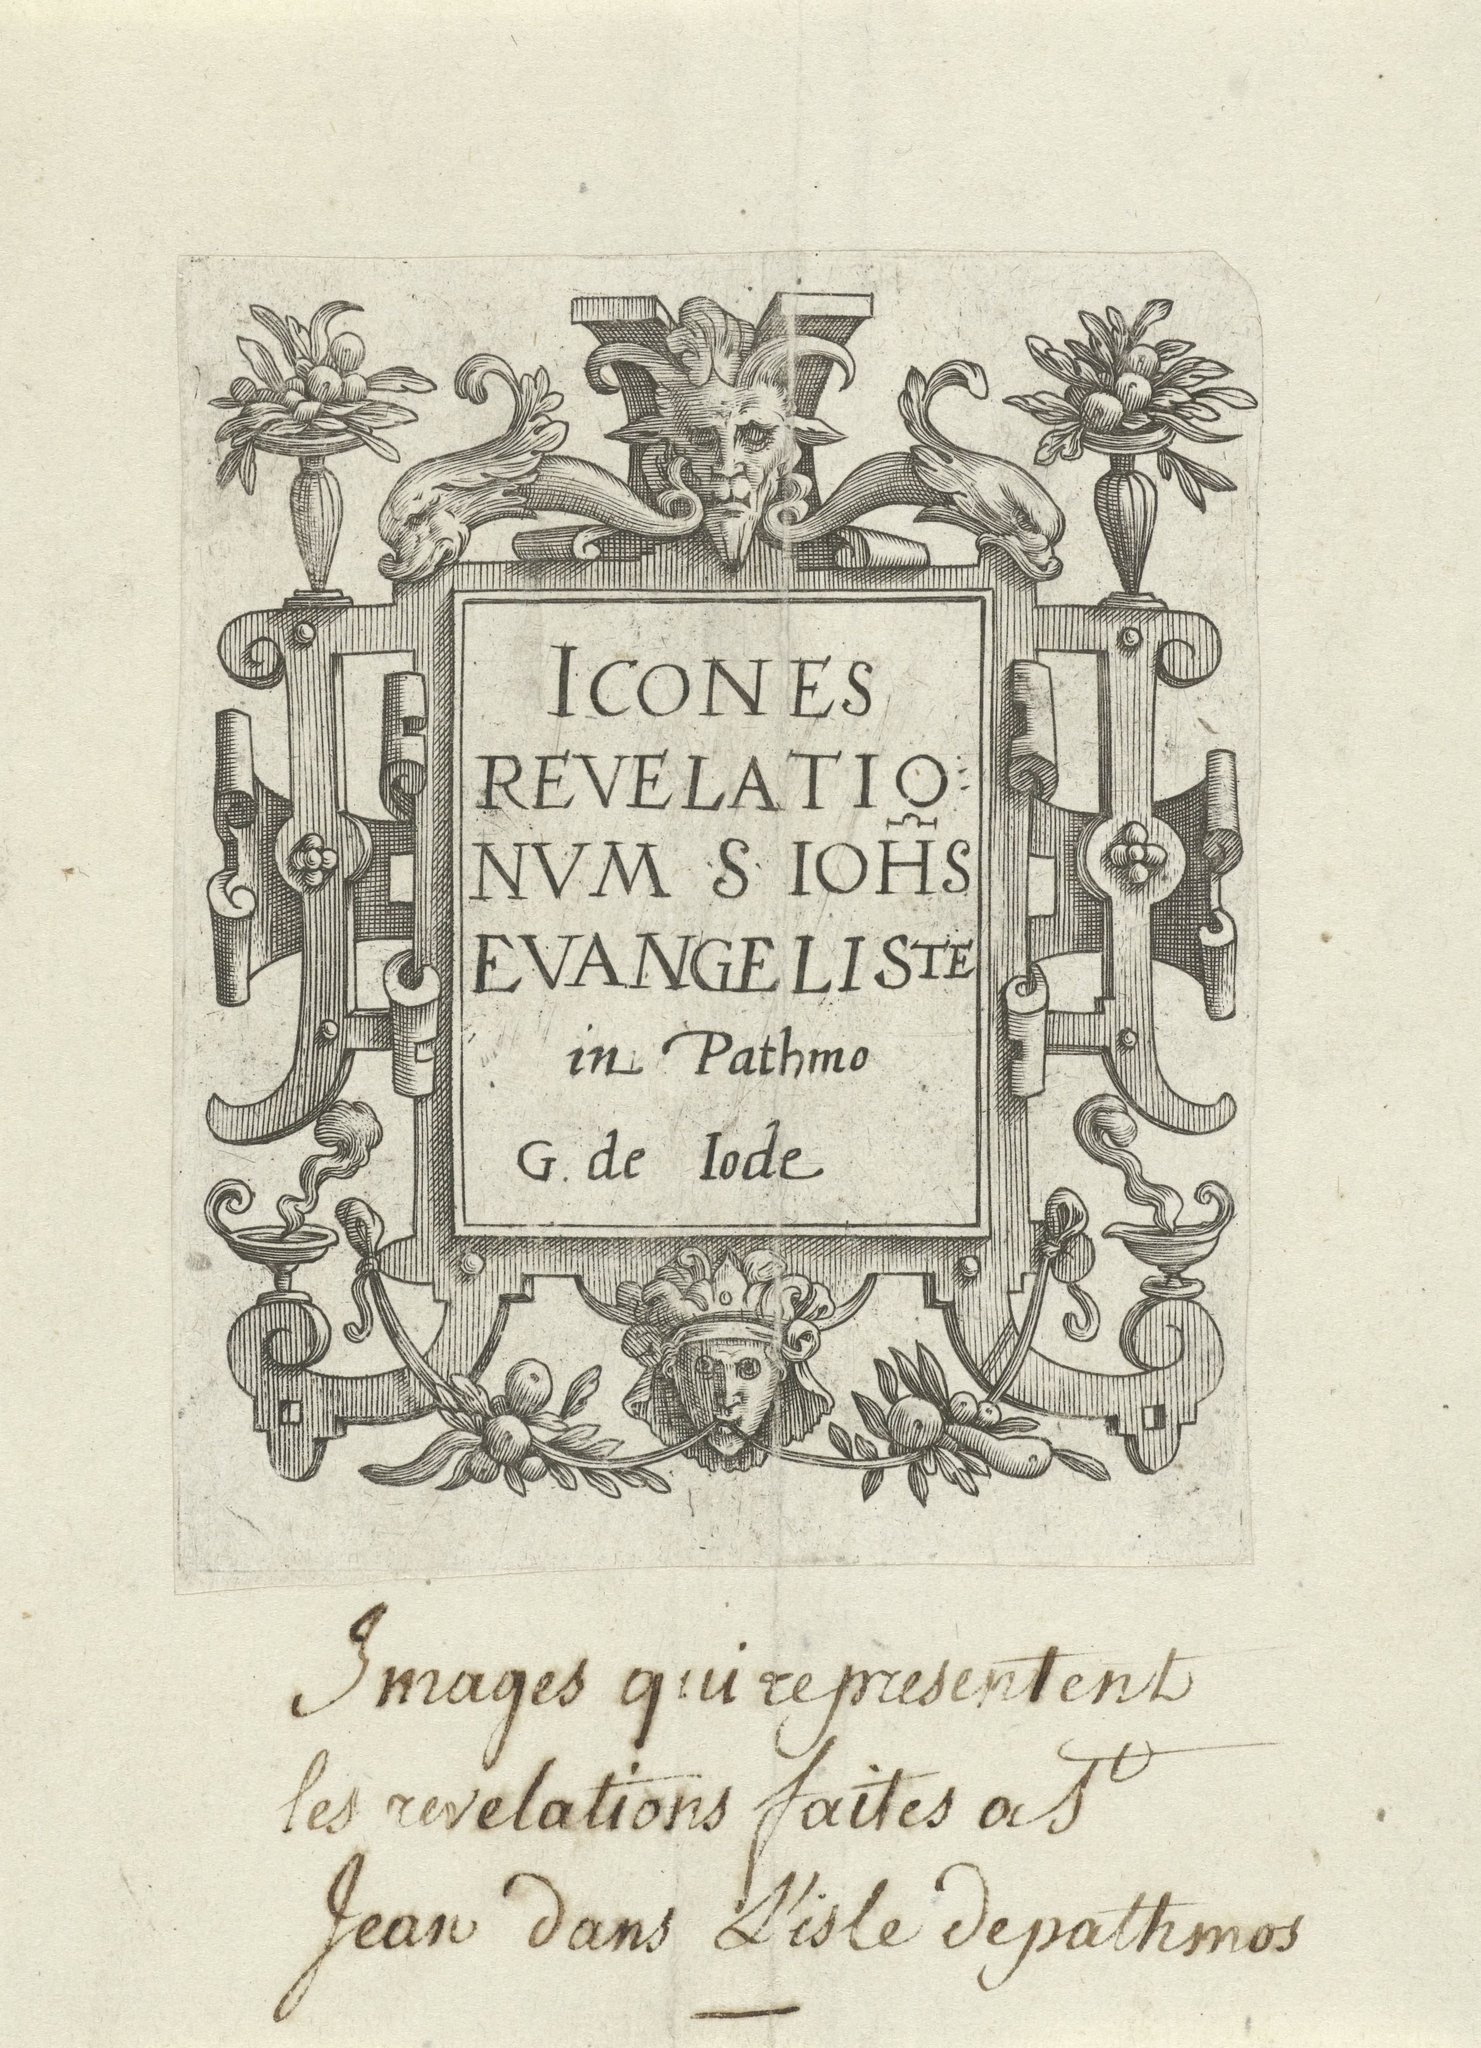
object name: print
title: Openbaring van Johannes op Patmos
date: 1585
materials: paper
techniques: engraving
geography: antwerp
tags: the revelation of john, the apocalypse, mask, mascaron ~ ornament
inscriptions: collector's mark: Lugt 2228, inscription: ‘Images qui [...] de Pathmos.’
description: Prent gebruikt in: Thesaurus sacrarum historiaru[m] veteris (et novi) testame[n]ti, elega[n]tissimis imaginibus expressu[m] excelle[n]tissimoru[m] in hac arte viroru[m] opera : nu[n]c primu[m] in luce[m] editus. Antwerpen: Gerard de Jode, 1585.